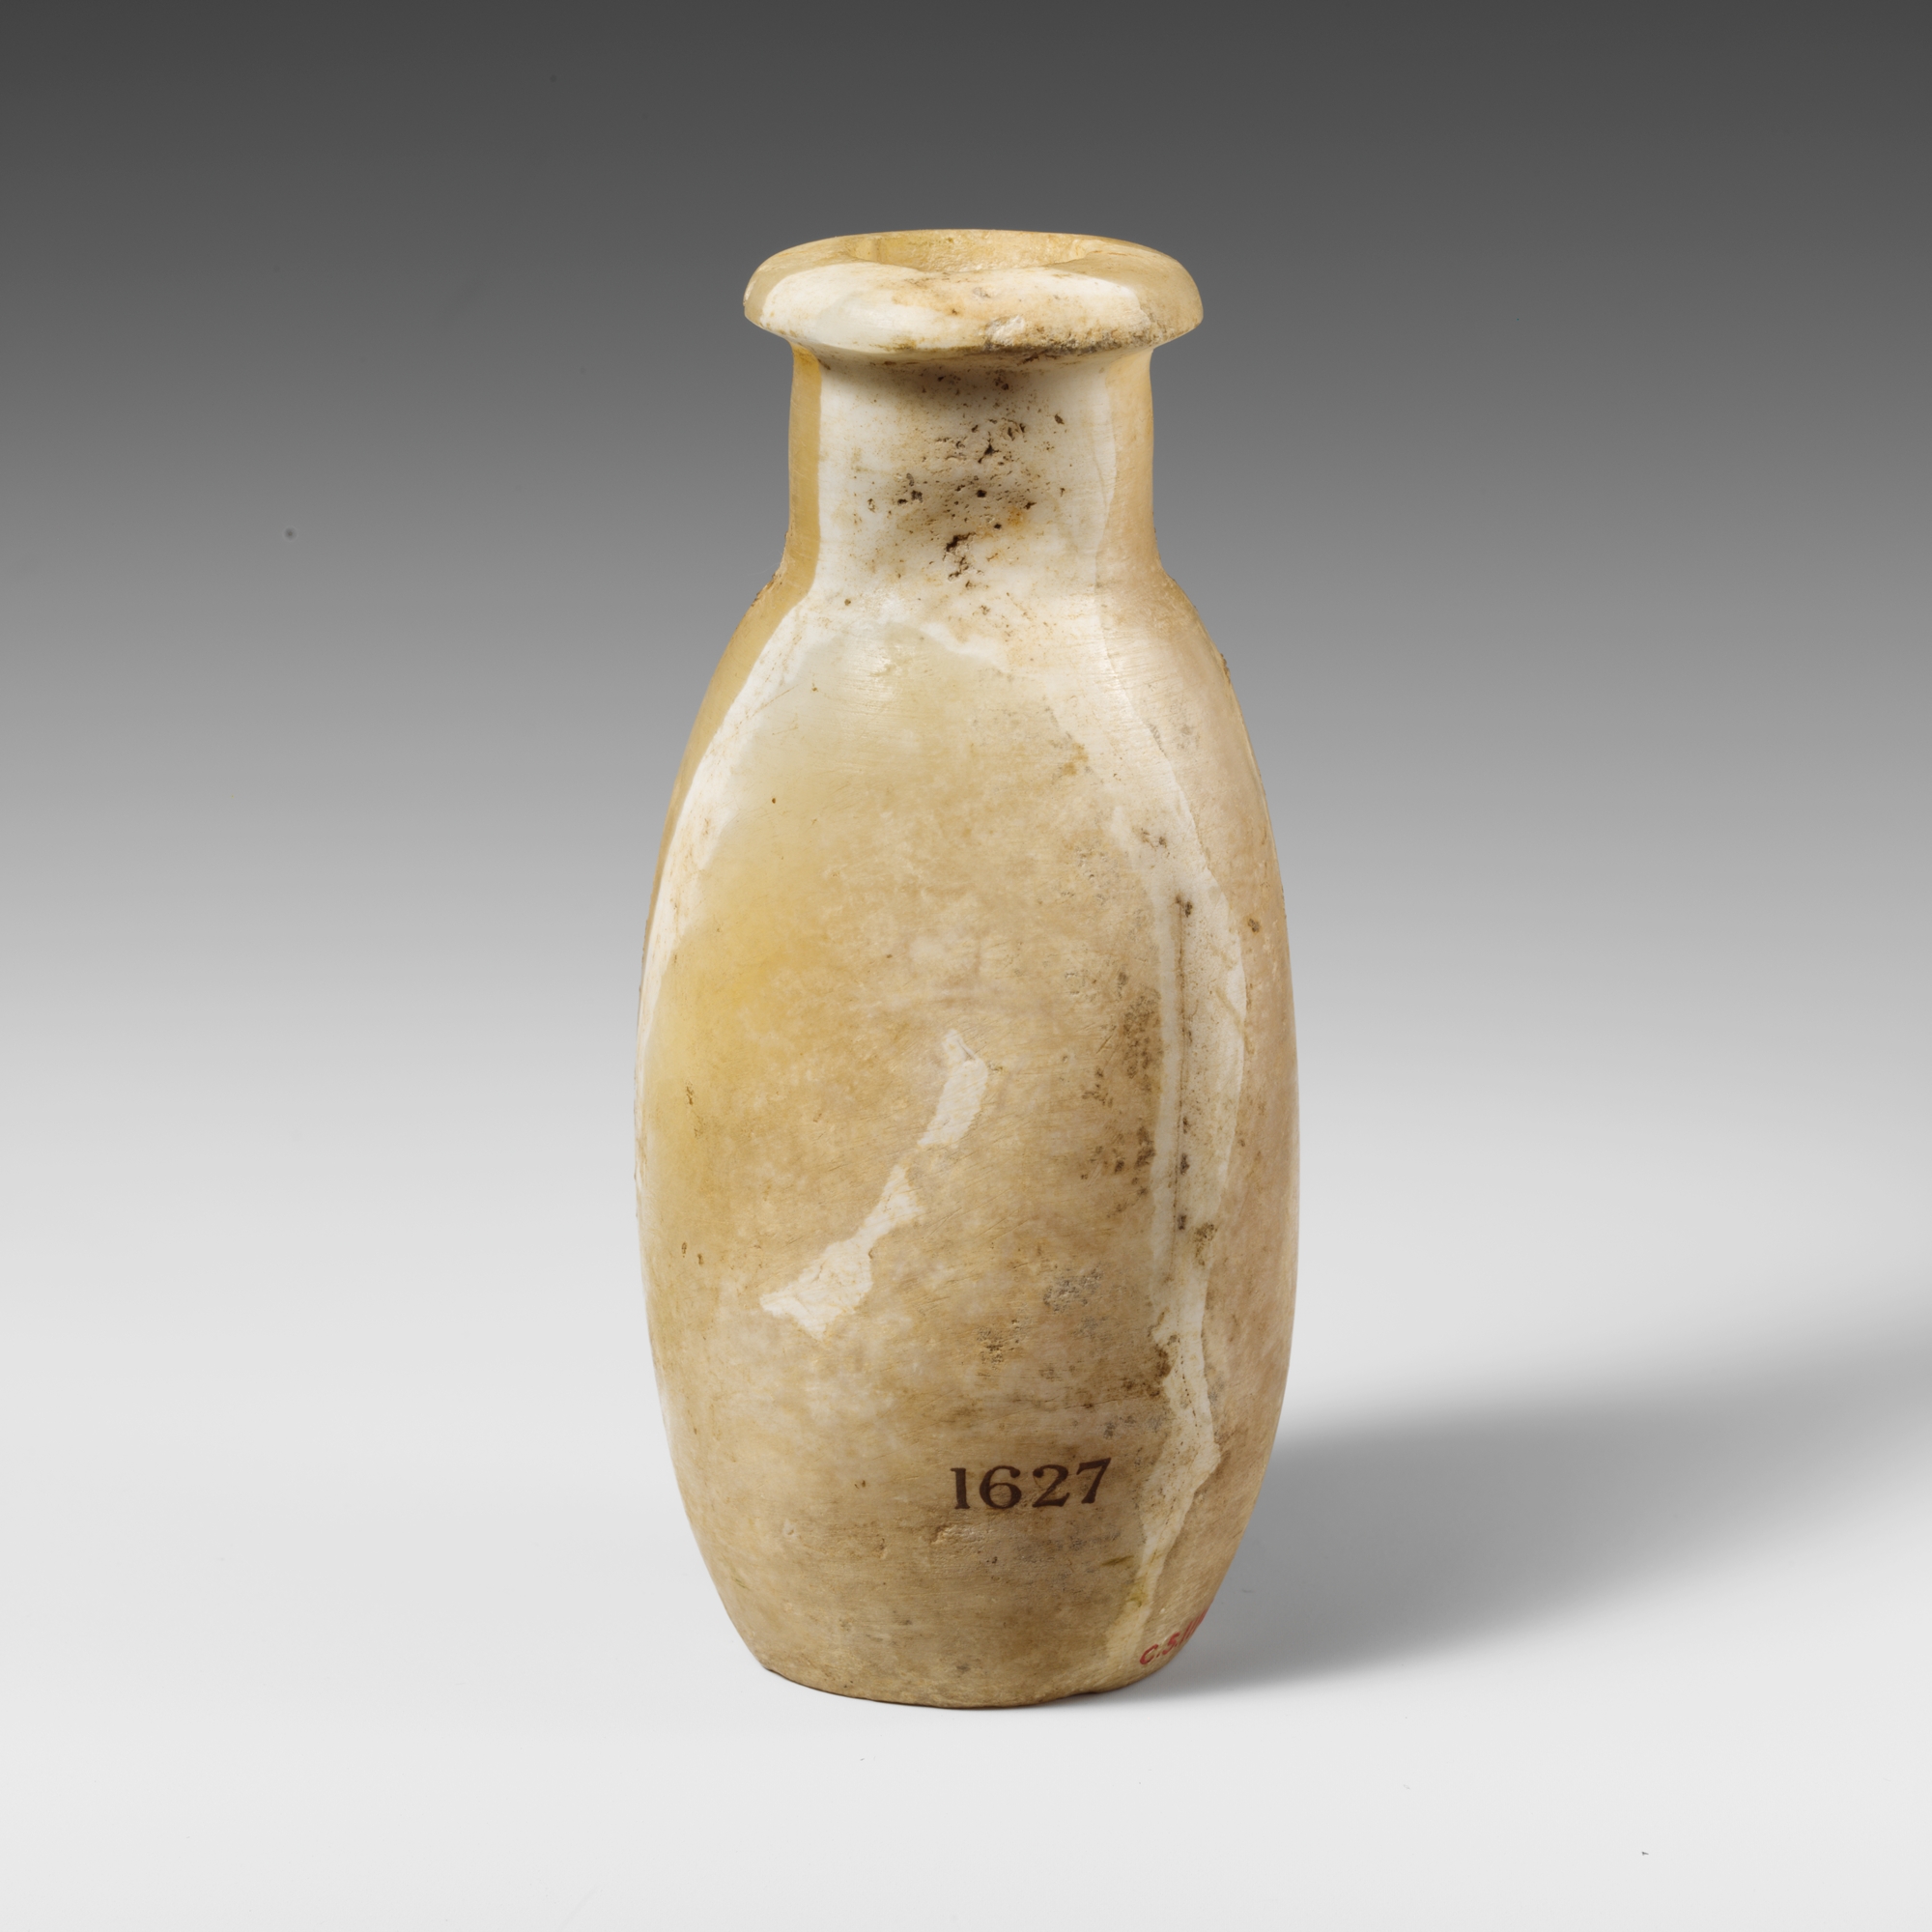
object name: flask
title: Alabaster flask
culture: cypriot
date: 1600-1050 BCE